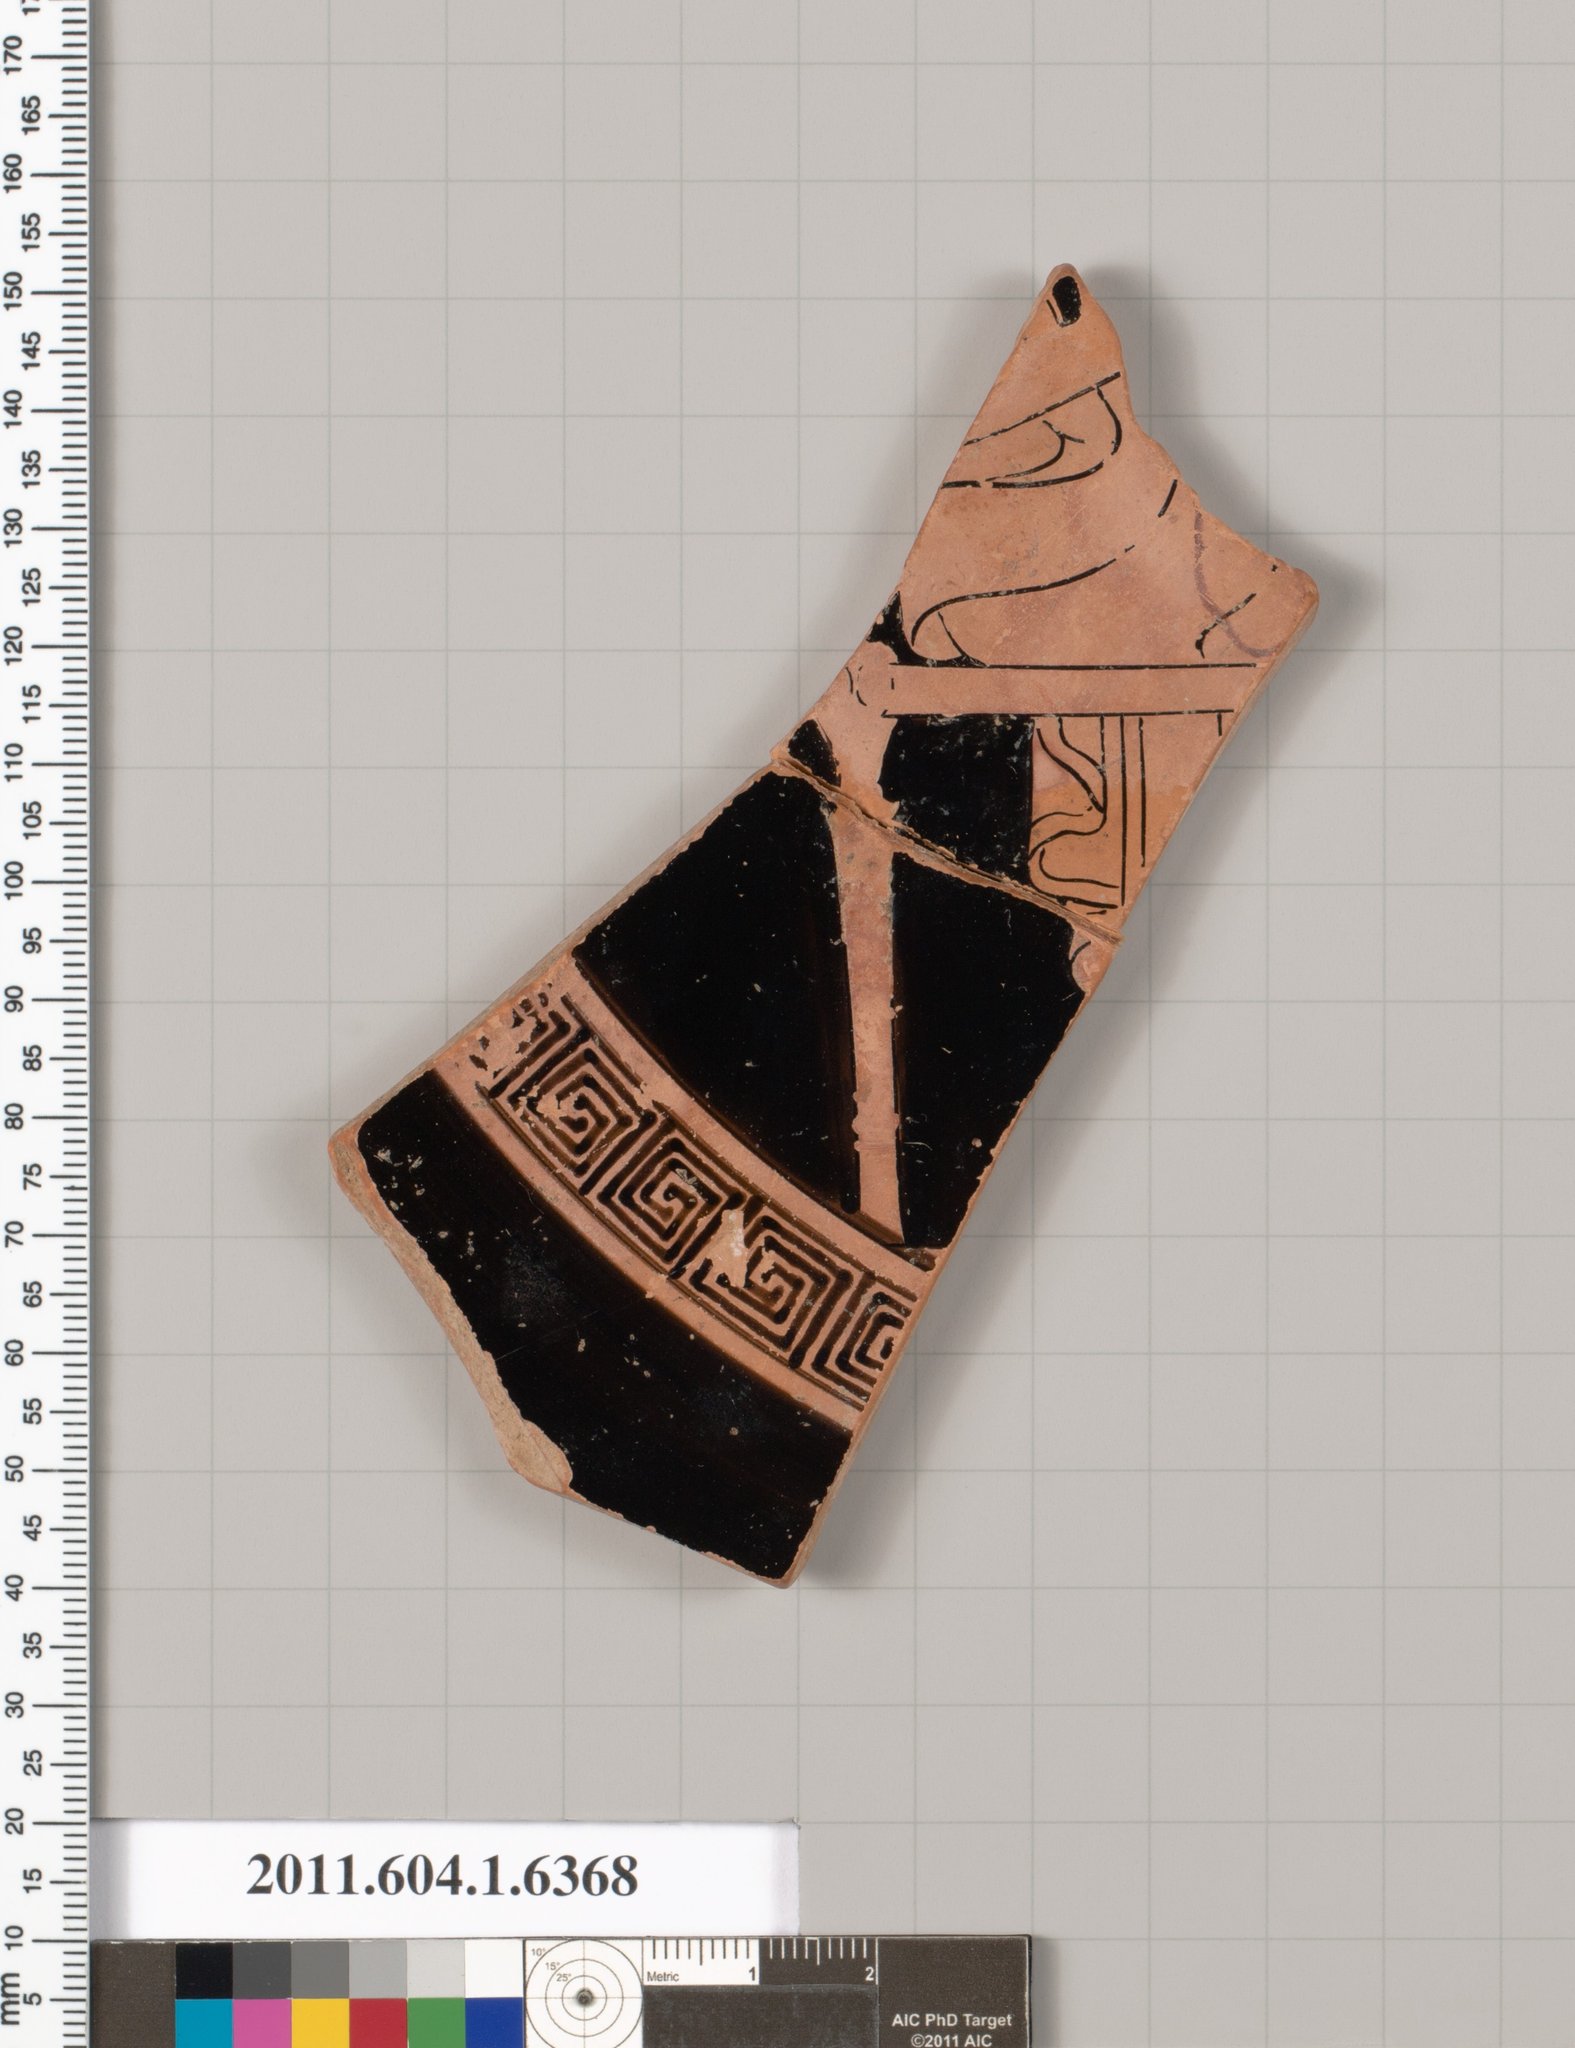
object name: kylix fragment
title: Terracotta fragment of a kylix (drinking cup)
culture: greek, attic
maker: antiphon painter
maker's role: artist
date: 490-480 BCE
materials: terracotta